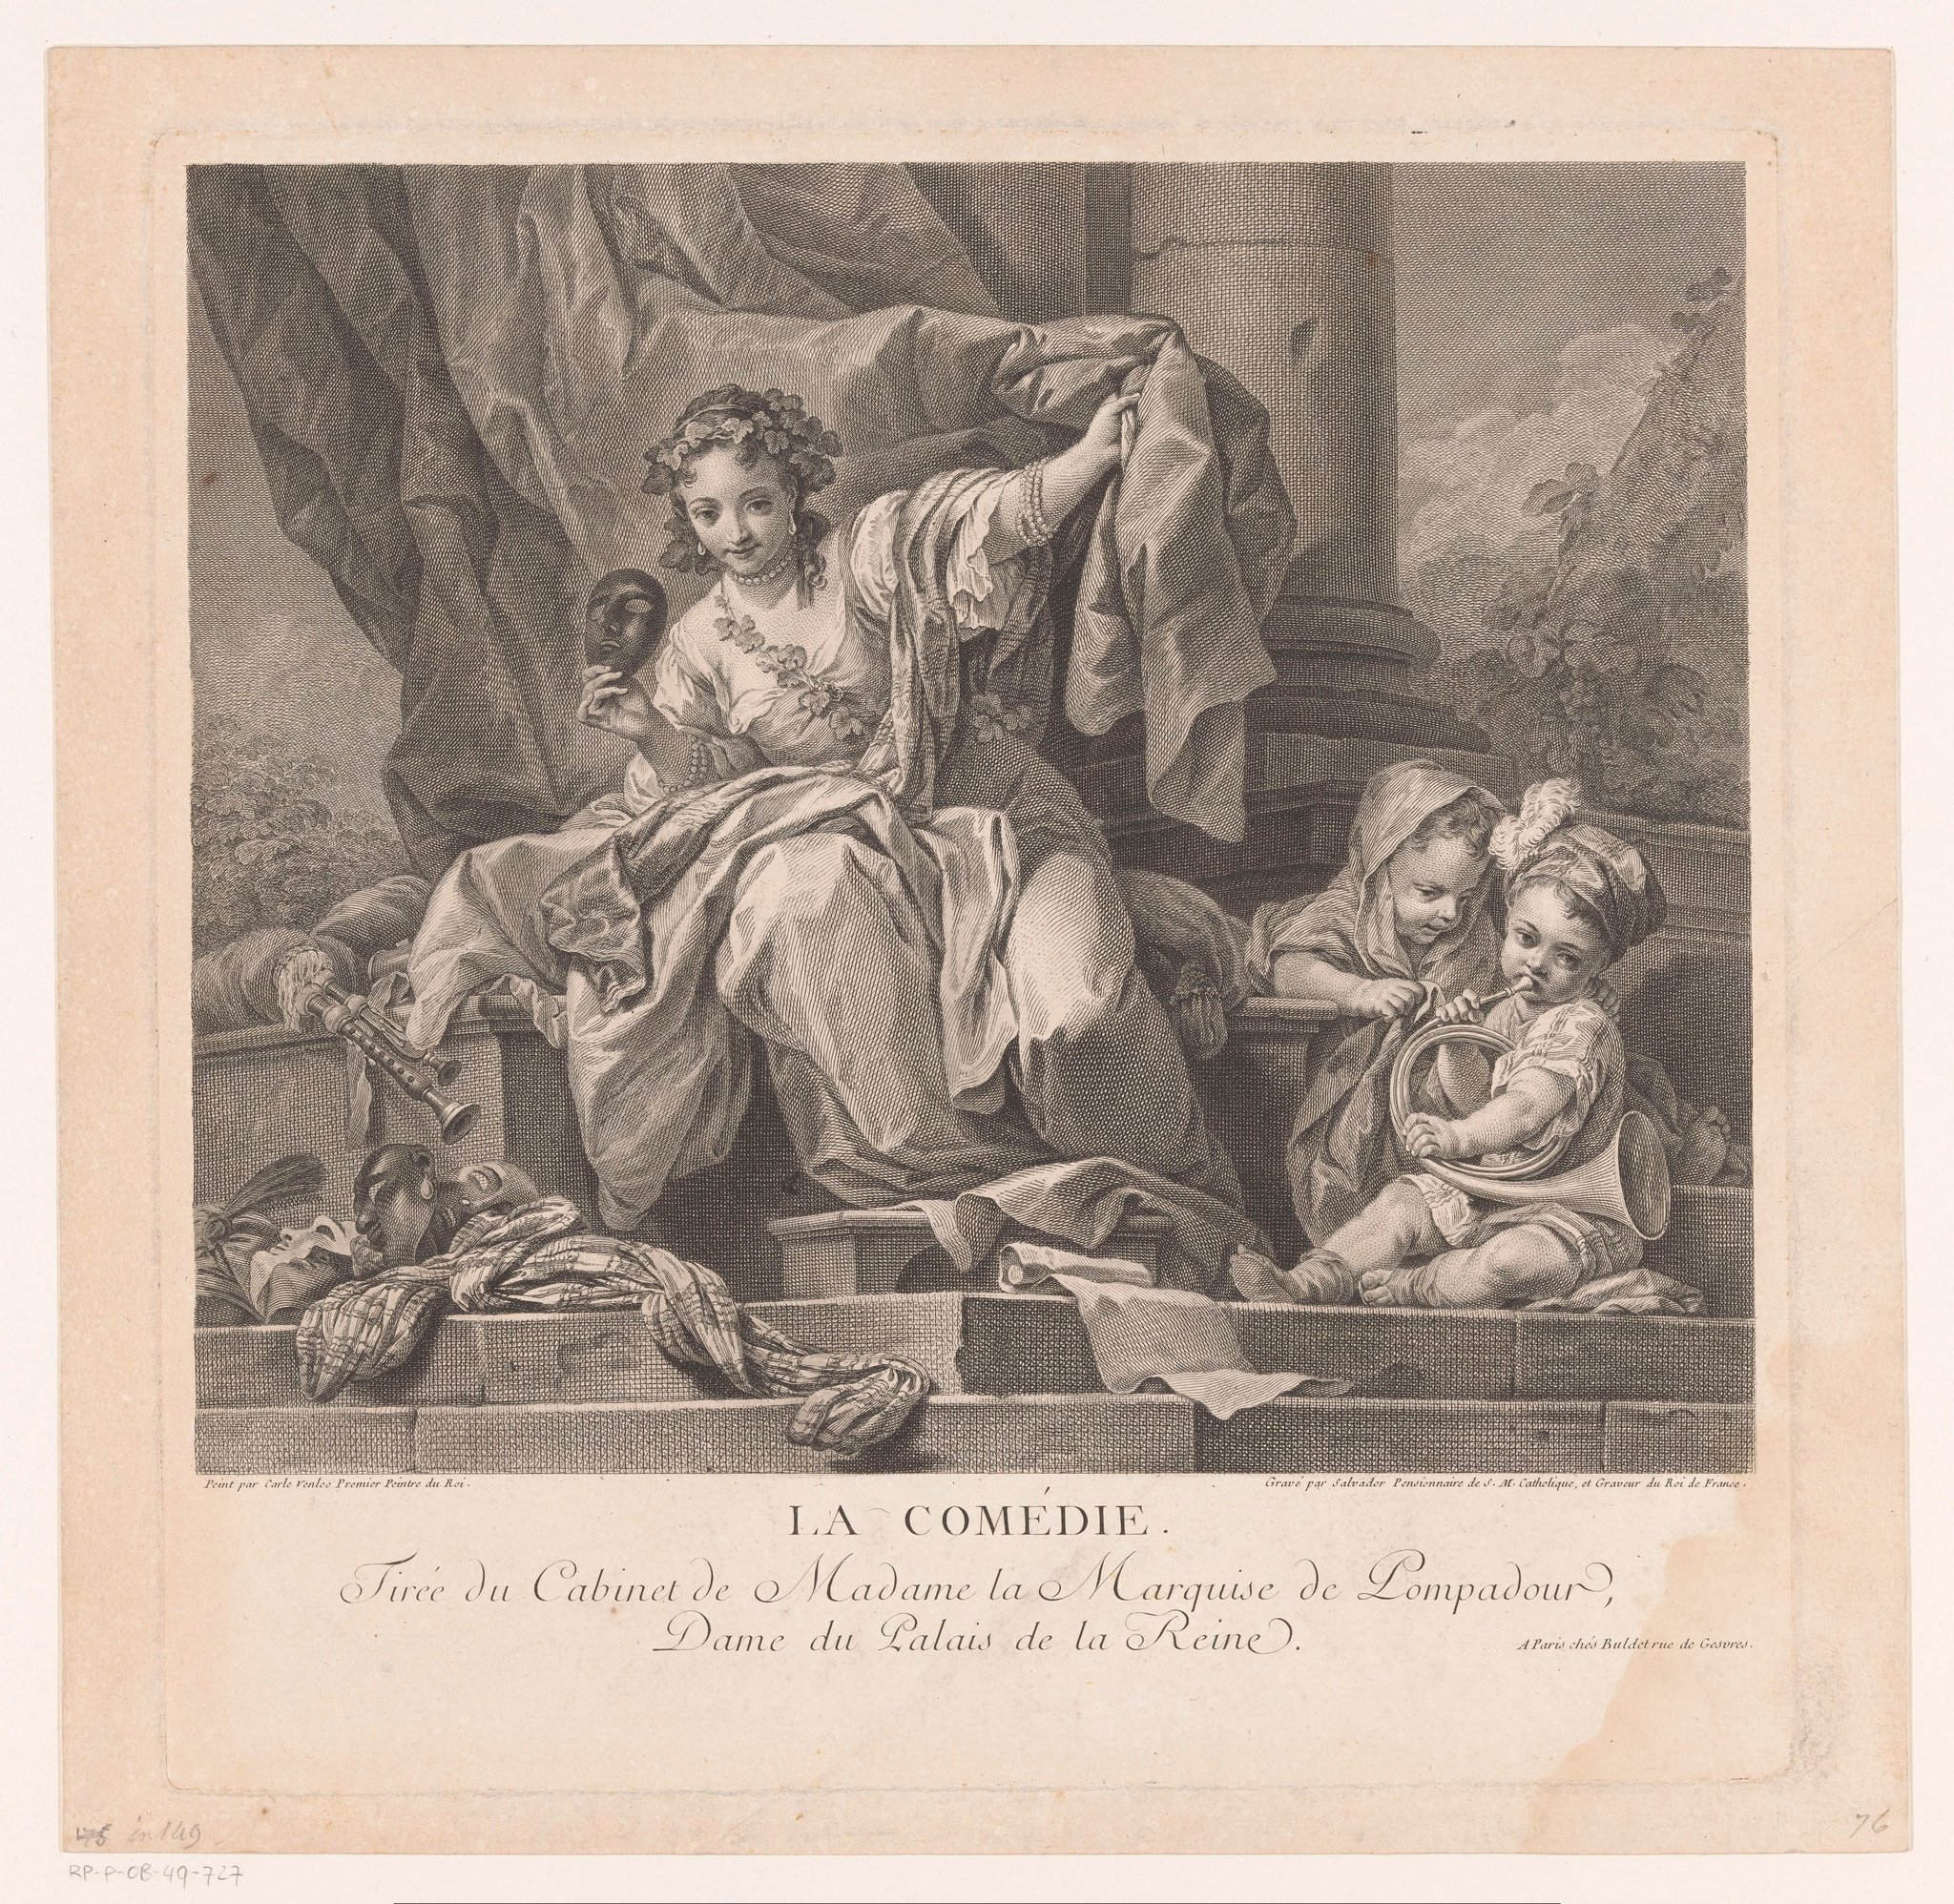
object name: print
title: Allegorie op de komedie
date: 1744-1820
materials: paper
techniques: engraving, etching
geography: spain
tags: mask, horn, trumpet, cornet, trombone, tuba, bagpipe, musette, comedy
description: Allegorie op de komedie met een jonge vrouw met een masker in de hand, zittend op een trap. Naast haar zitten twee kinderen waarvan één de hoorn bespeelt. Op de traptreden liggen onder meer maskers en een doedelzak.